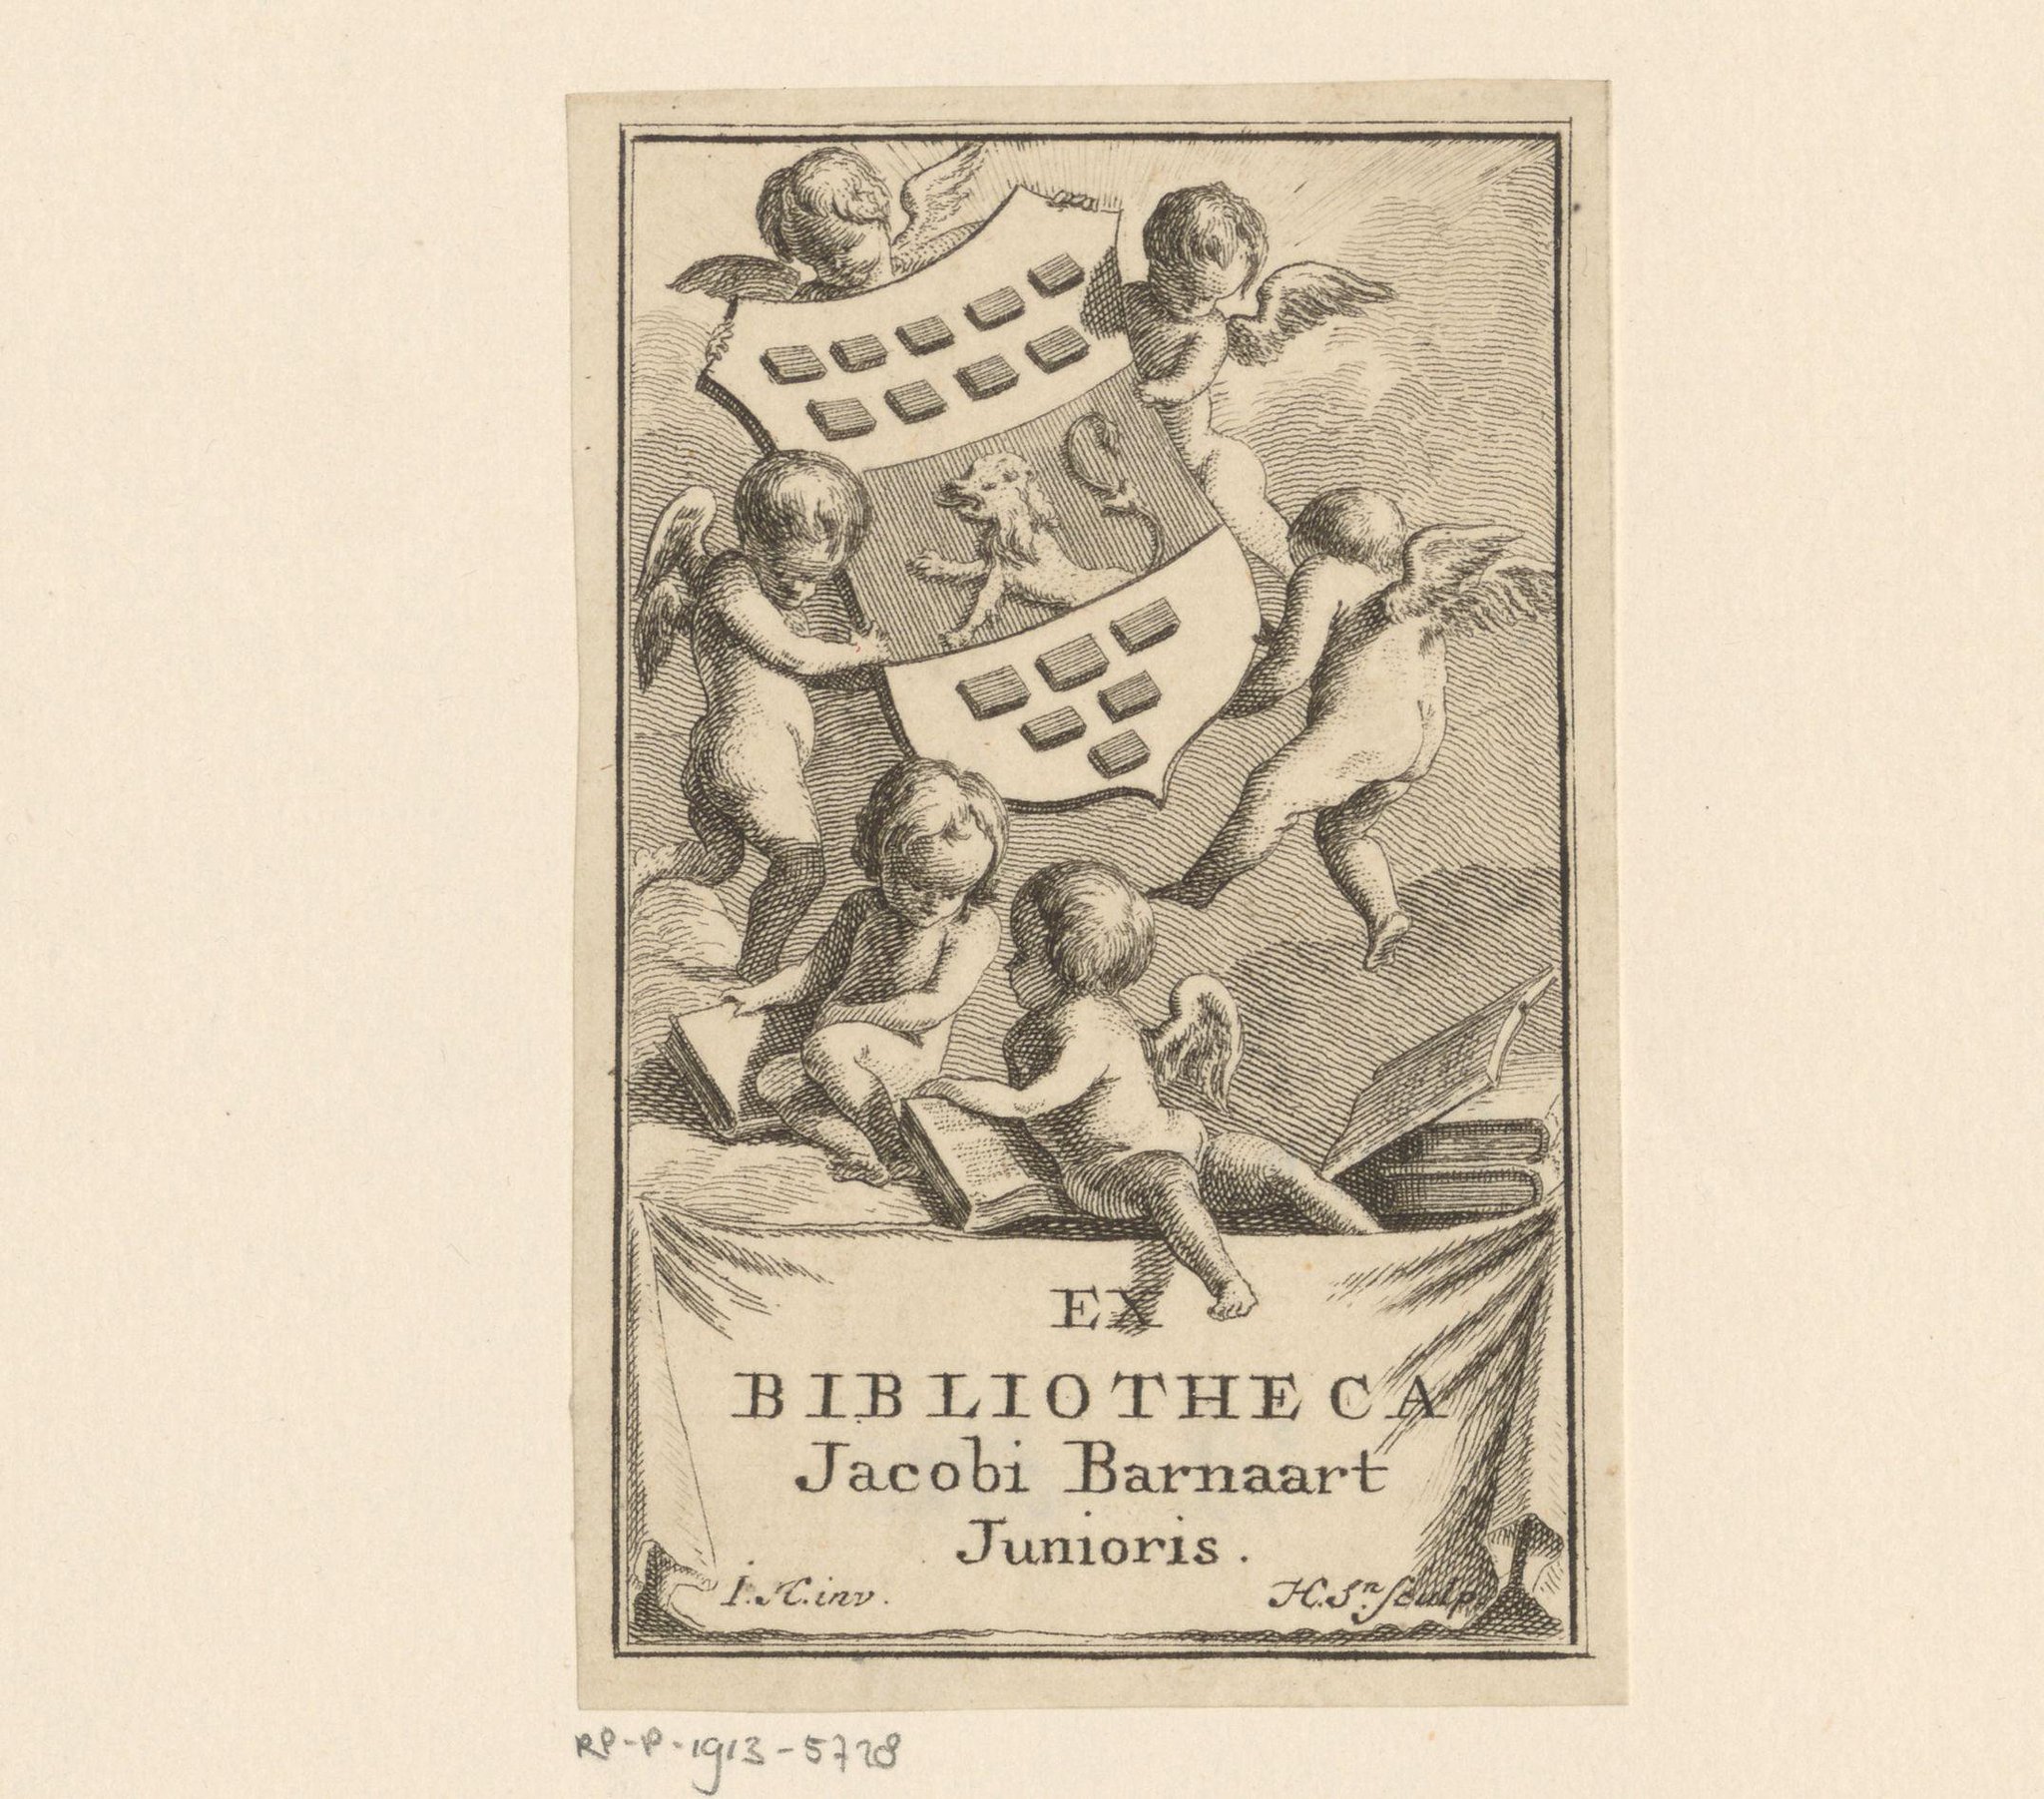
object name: bookplate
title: Ex bibliotheca Jacobi Barnaart junioris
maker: Anonymous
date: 1700-1749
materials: paper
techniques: etching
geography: netherlands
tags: book, beasts of prey, predatory animals: lion, cupids: 'amores', 'amoretti', 'putti', armorial bearing, heraldry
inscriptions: collector's mark: Lugt 2233, collector's mark: Lugt 2760